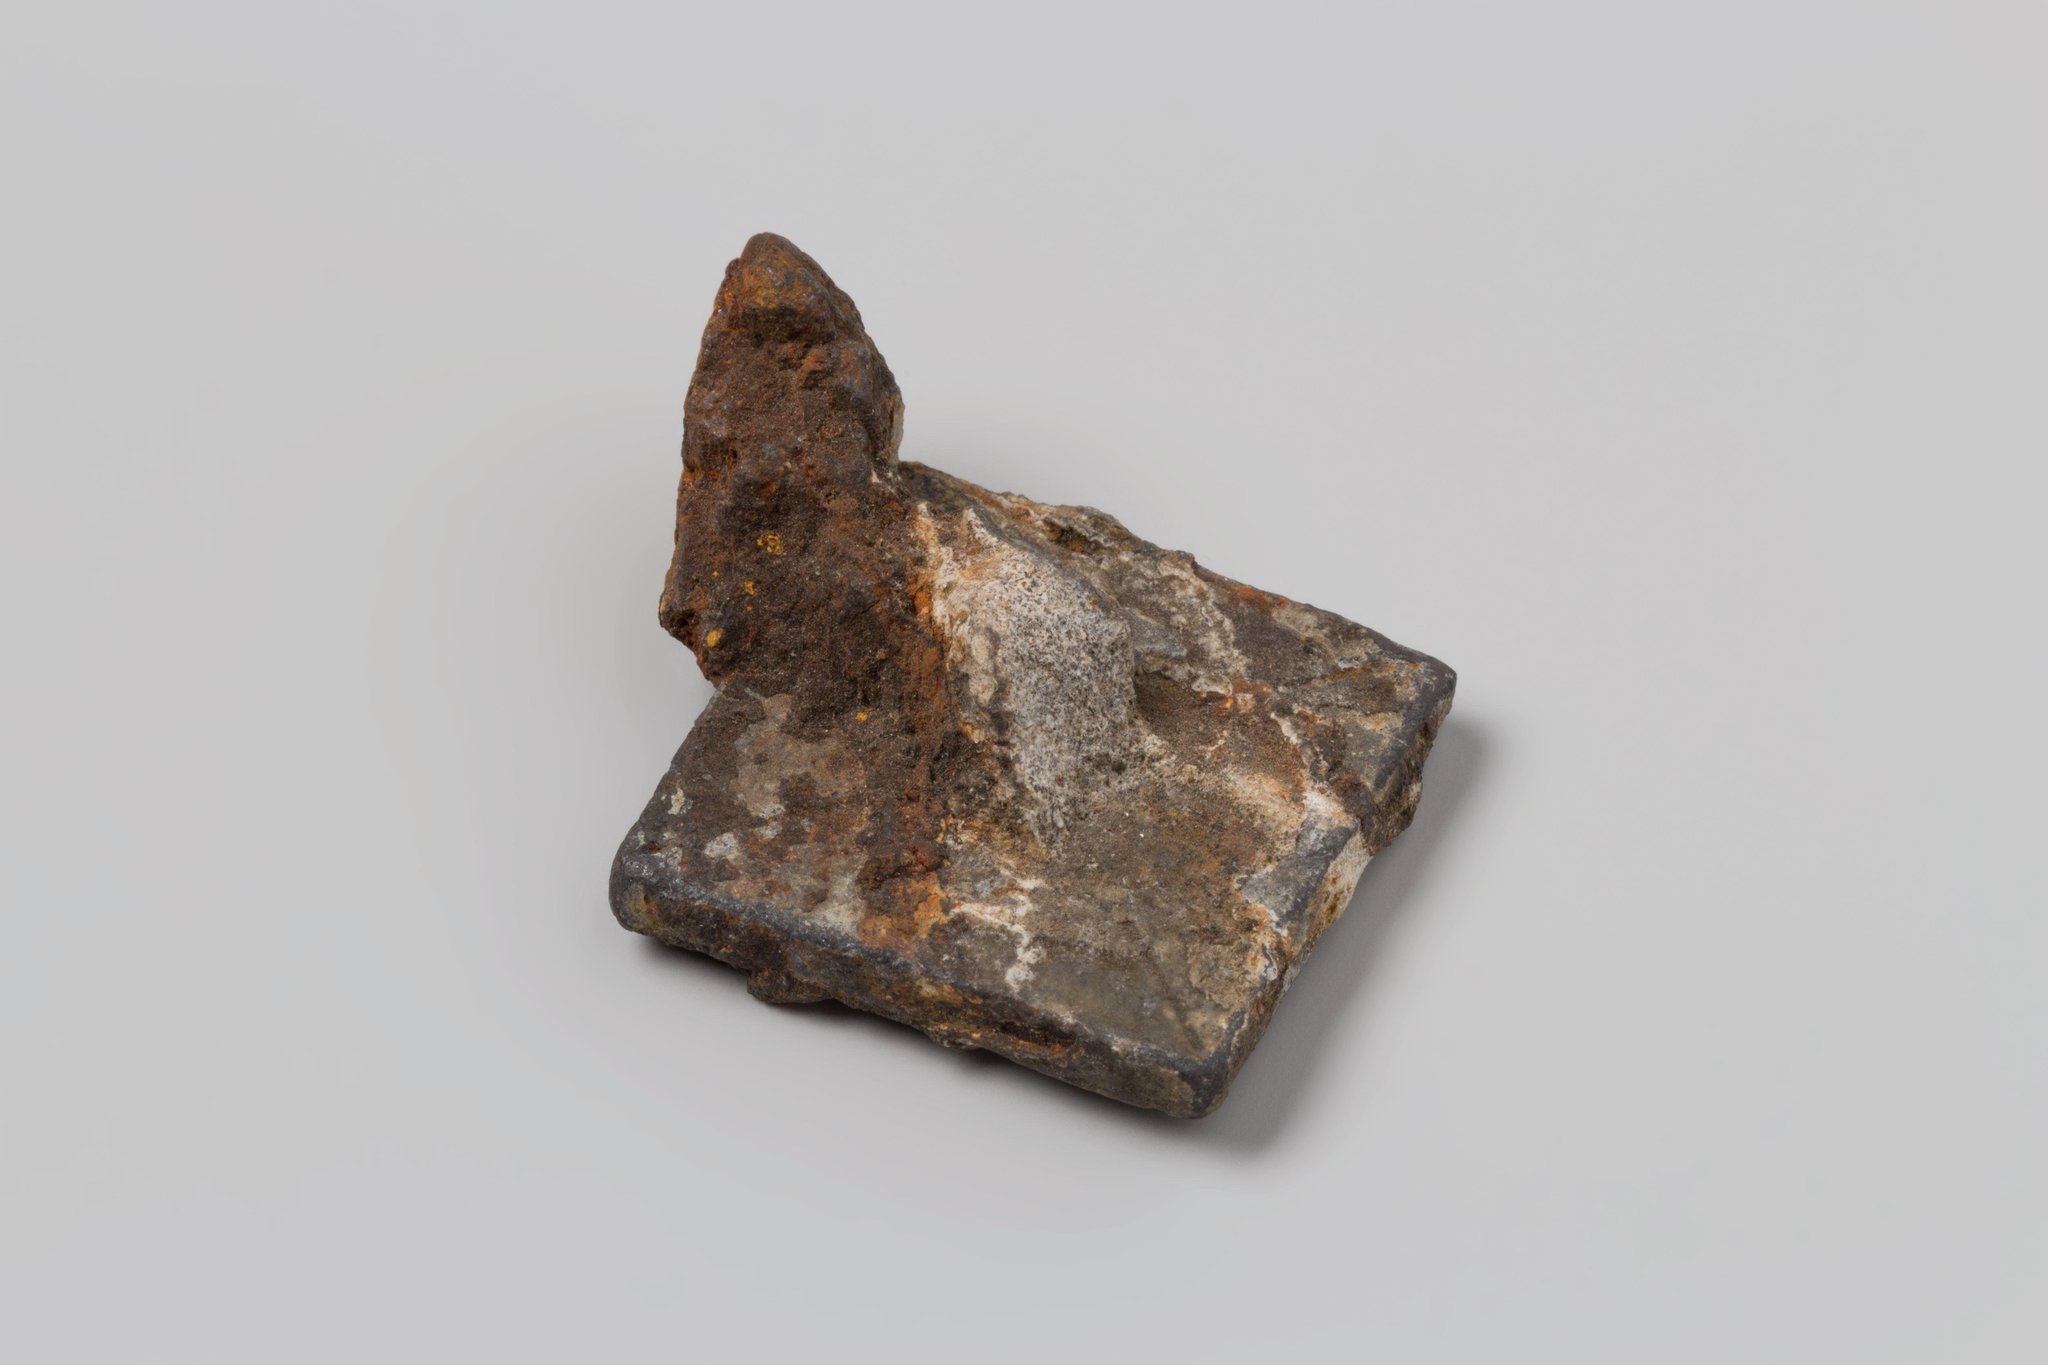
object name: gaming counter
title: Speelpenning uit het wrak van de Oost-Indiëvaarder Hollandia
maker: Anonymous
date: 1700-1743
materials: lead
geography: netherlands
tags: verenigde oostindische compagnie, hollandia (schip), annet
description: Rectangular, square, flat, engraved diagonal cross on one side, game token.